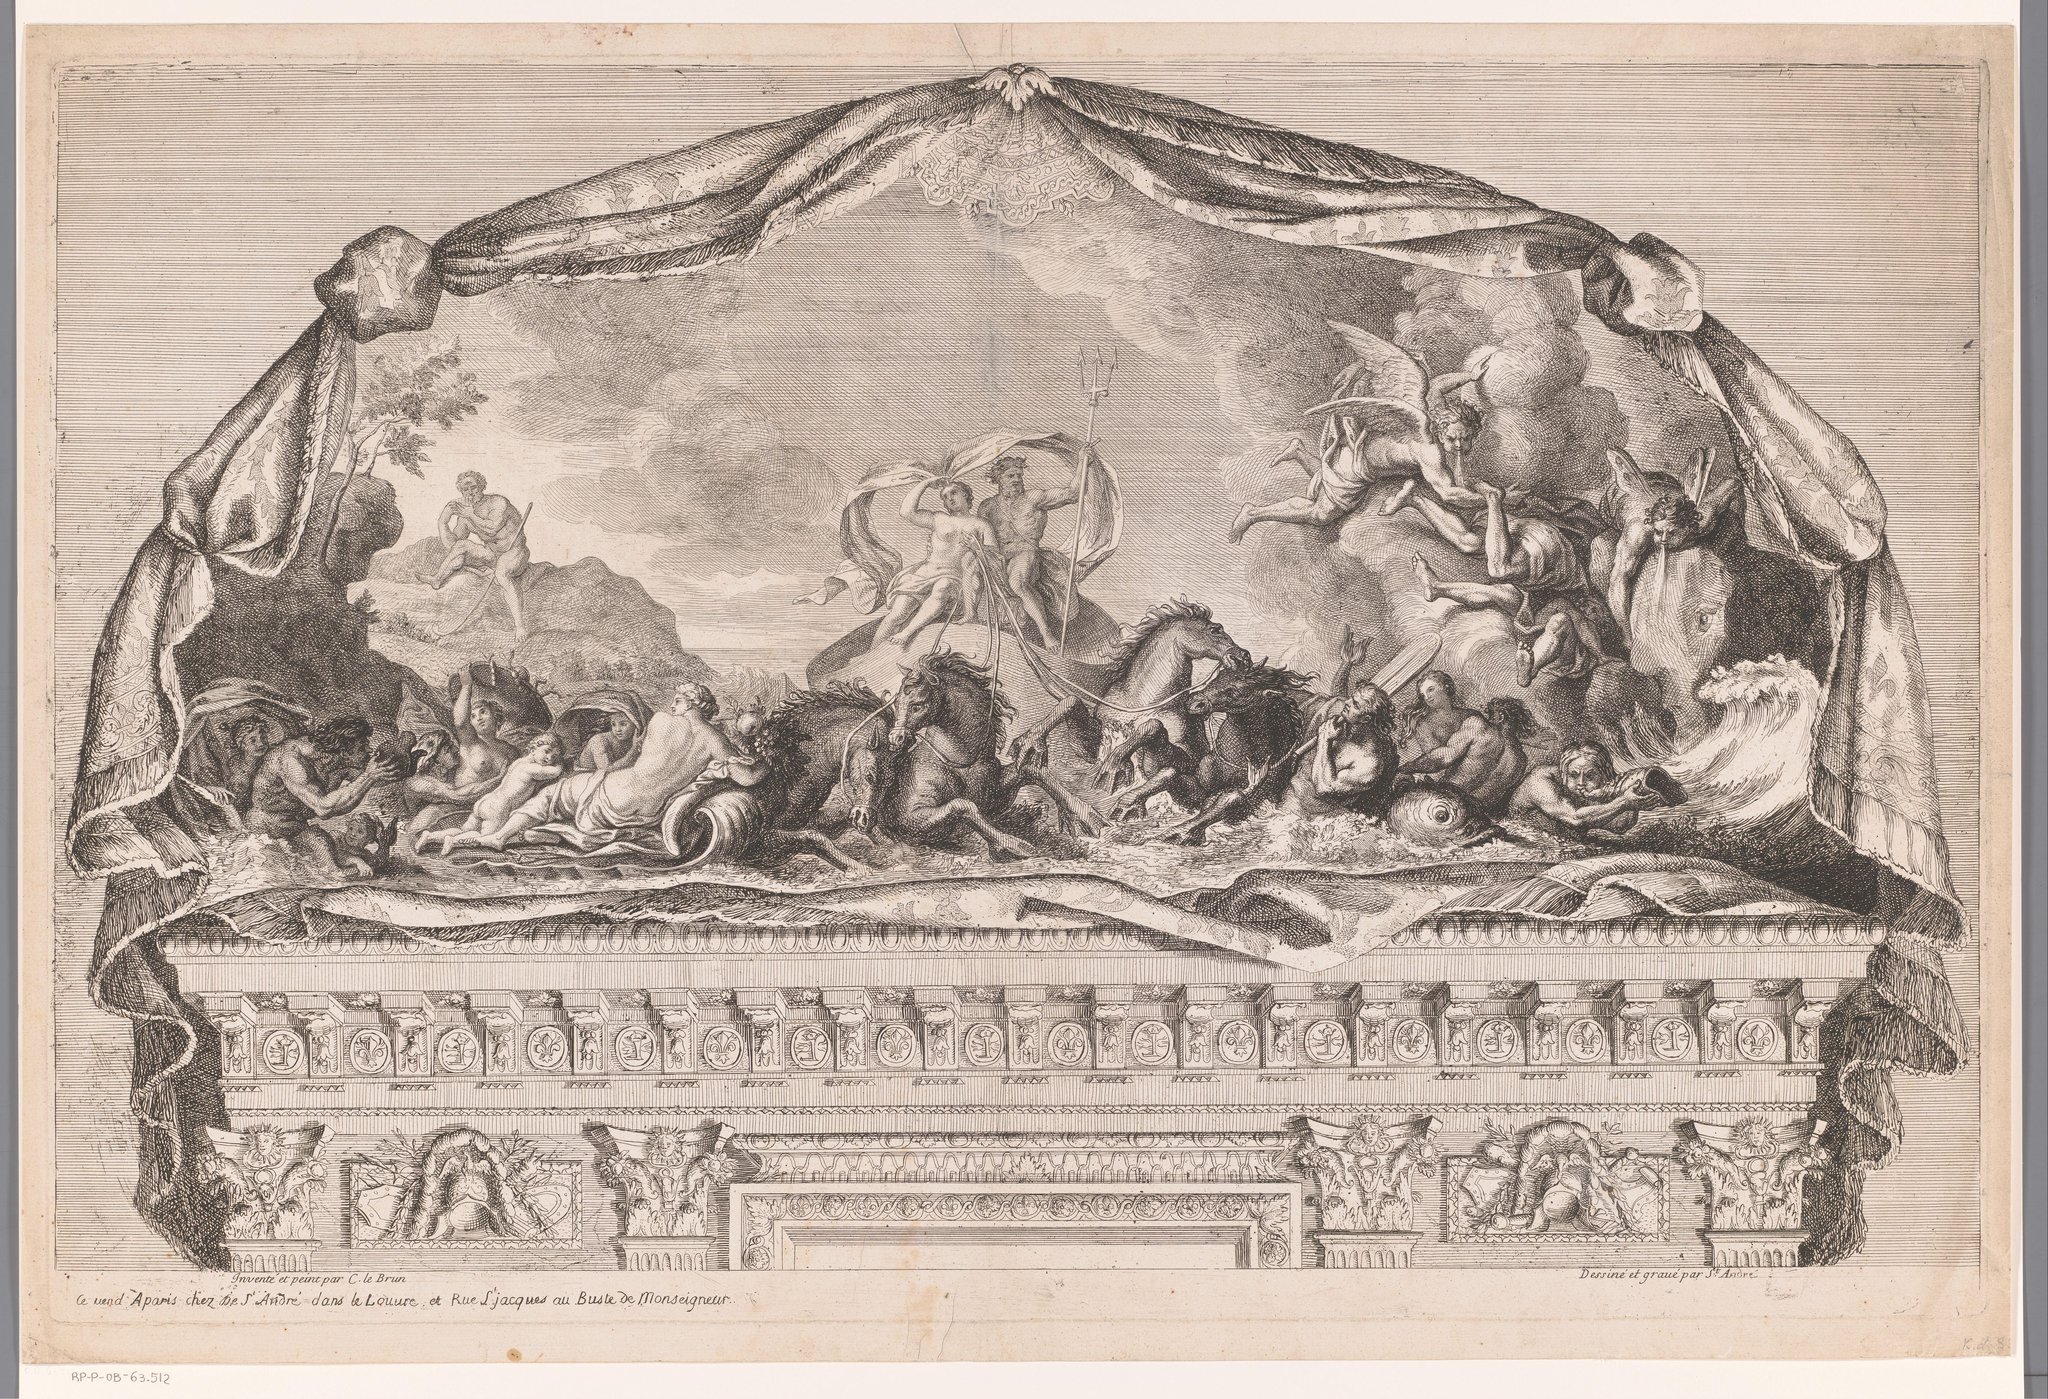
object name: print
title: Galerie d'Apollon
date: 1695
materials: paper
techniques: etching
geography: paris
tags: triumph of neptune and amphitrite, with a retinue of tritons and nereids, i.e. marriage train, other nereids (or sea-nymphs)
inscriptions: collector's mark: Lugt 240